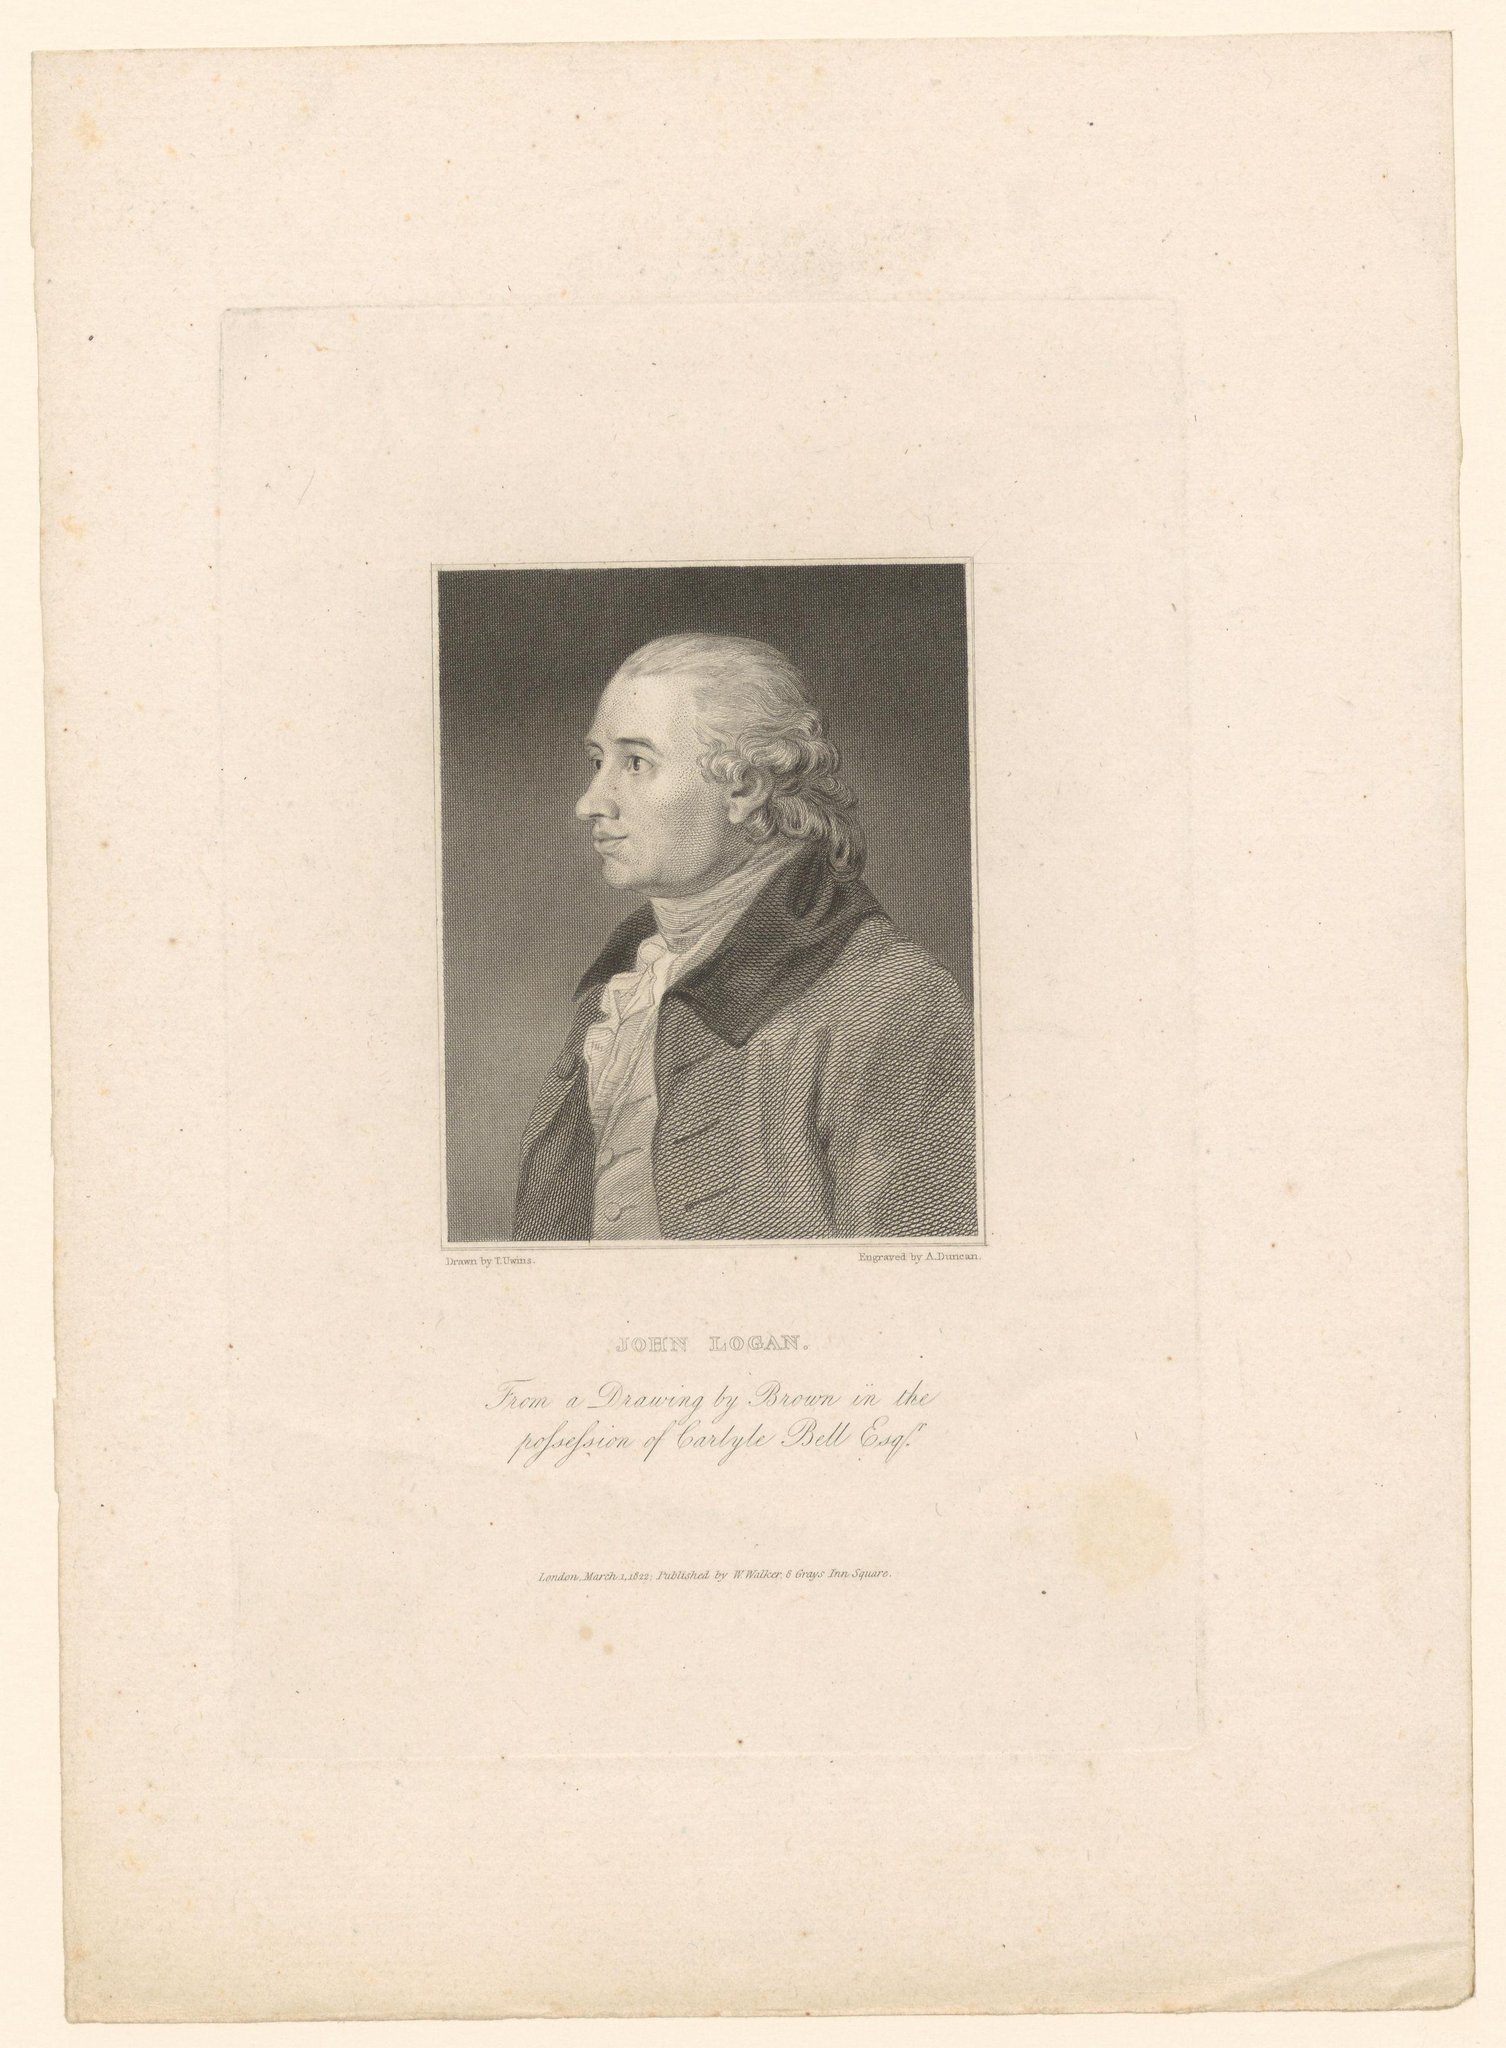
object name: print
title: Portret van John Logan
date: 1822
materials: paper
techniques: engraving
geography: london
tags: london, historical persons, politician, e.g. party leader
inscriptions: collector's mark: Lugt 2228